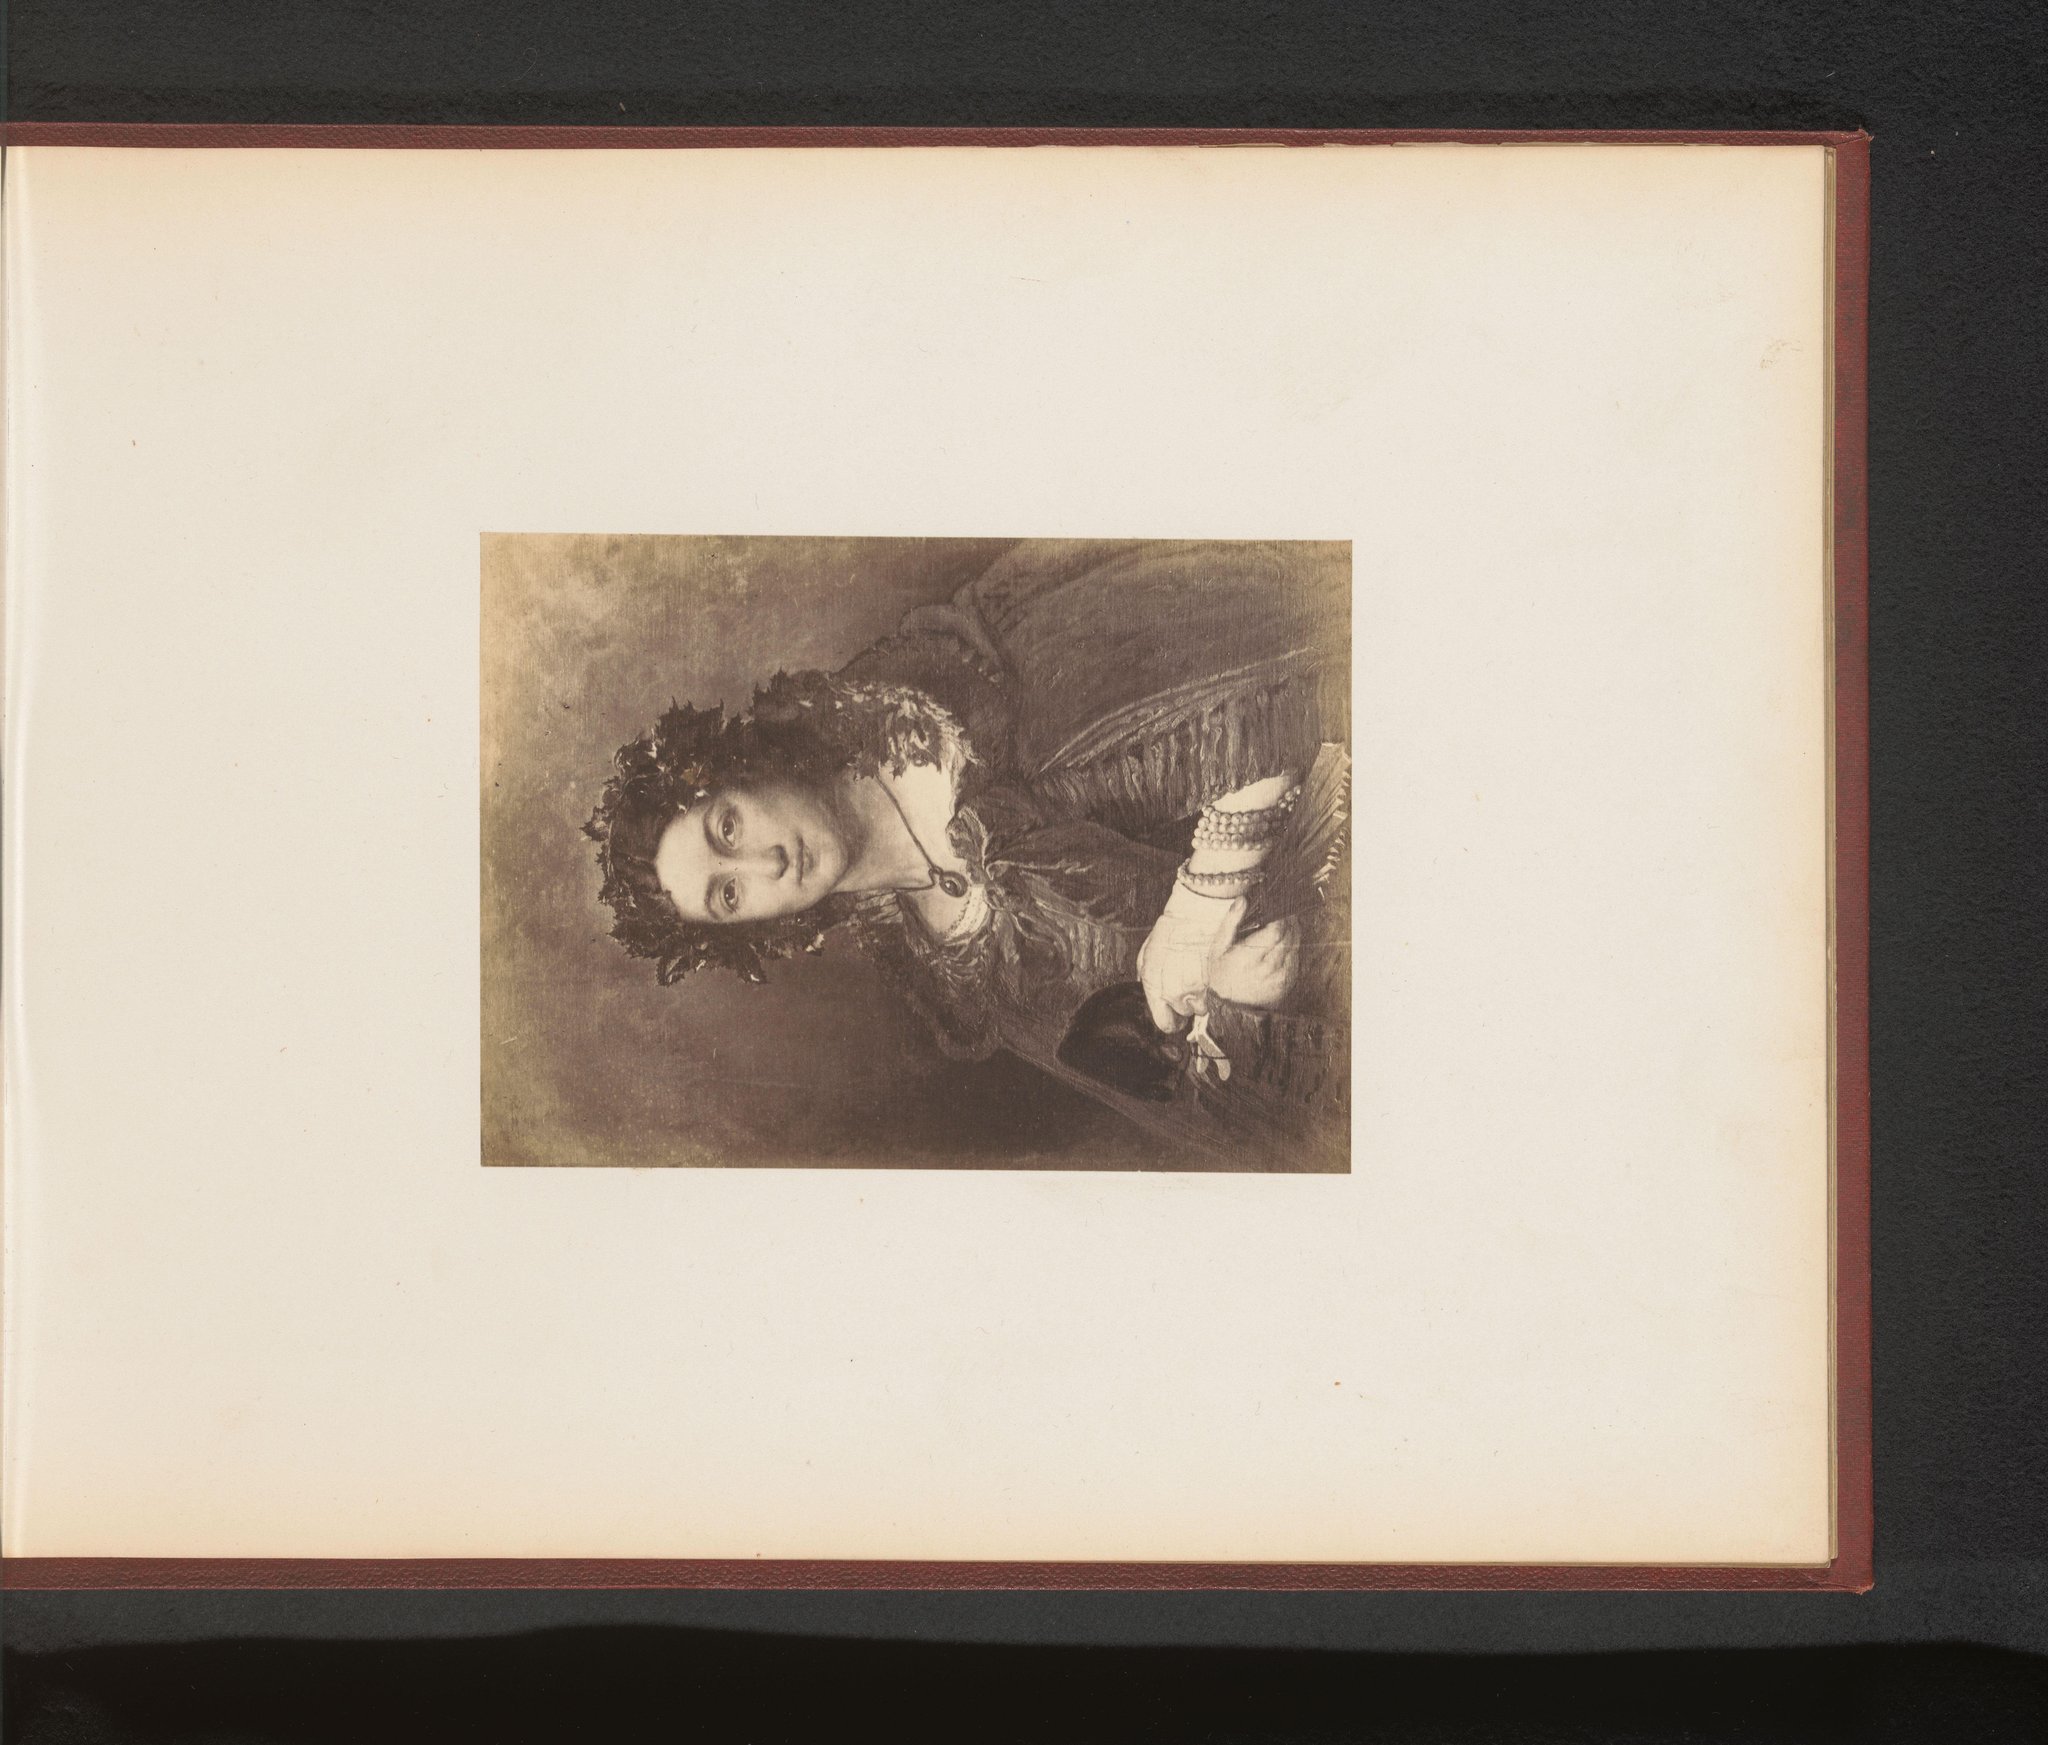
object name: page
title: Fotoreproductie van Le Domino van Jan Frans Portaels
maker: Anonymous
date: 1858-1863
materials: photographic support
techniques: albumen print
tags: adult woman, picture, painting